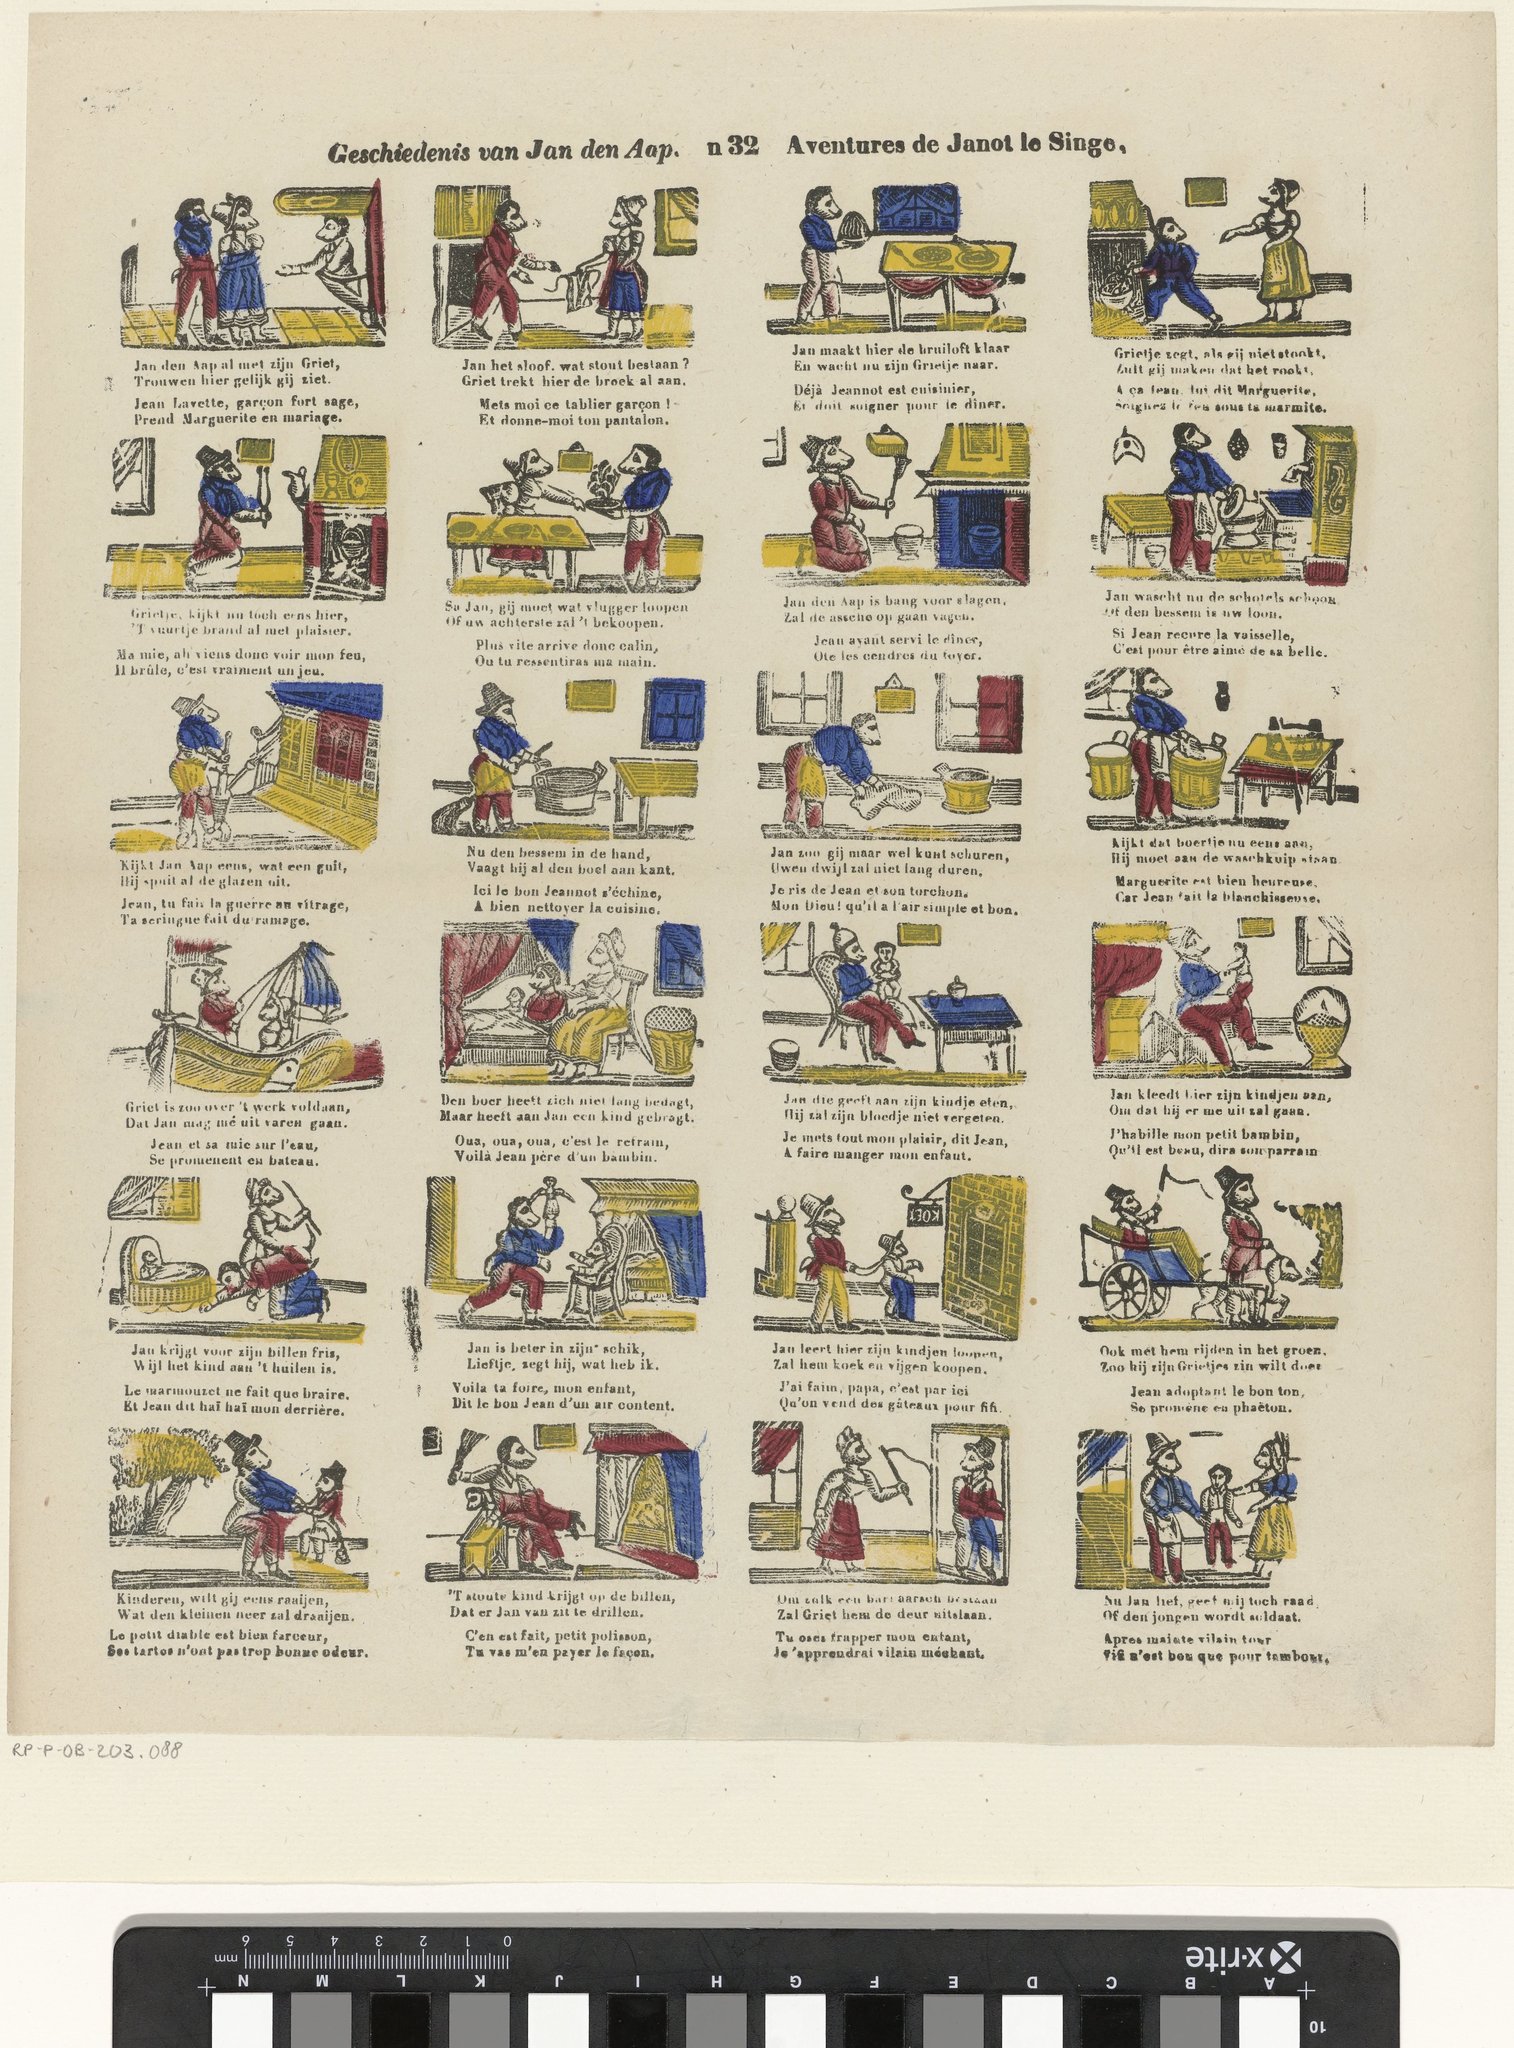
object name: print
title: Geschiedenis van Jan den Aap / Aventures de Janot le Singe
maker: Anonymous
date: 1856-1900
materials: paper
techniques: colour, letterpress printing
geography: turnhout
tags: hen-pecked husband, 'betty', 'molly' (man who engages in women's work), monkeys, apes, animals acting as human beings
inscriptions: collector's mark: Lugt 2760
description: Blad met 24 voorstellingen uit het leven van Jan de Wasser, een man die van zijn vrouw Griet, die de broek aan heeft, al het huishoudelijk werk moet doen. Uitgebeeld met apen in plaats van mensen. Onder elke voorstelling een tweeregelig vers in het Nederlands en in het Frans. Genummerd midden boven: n 32.